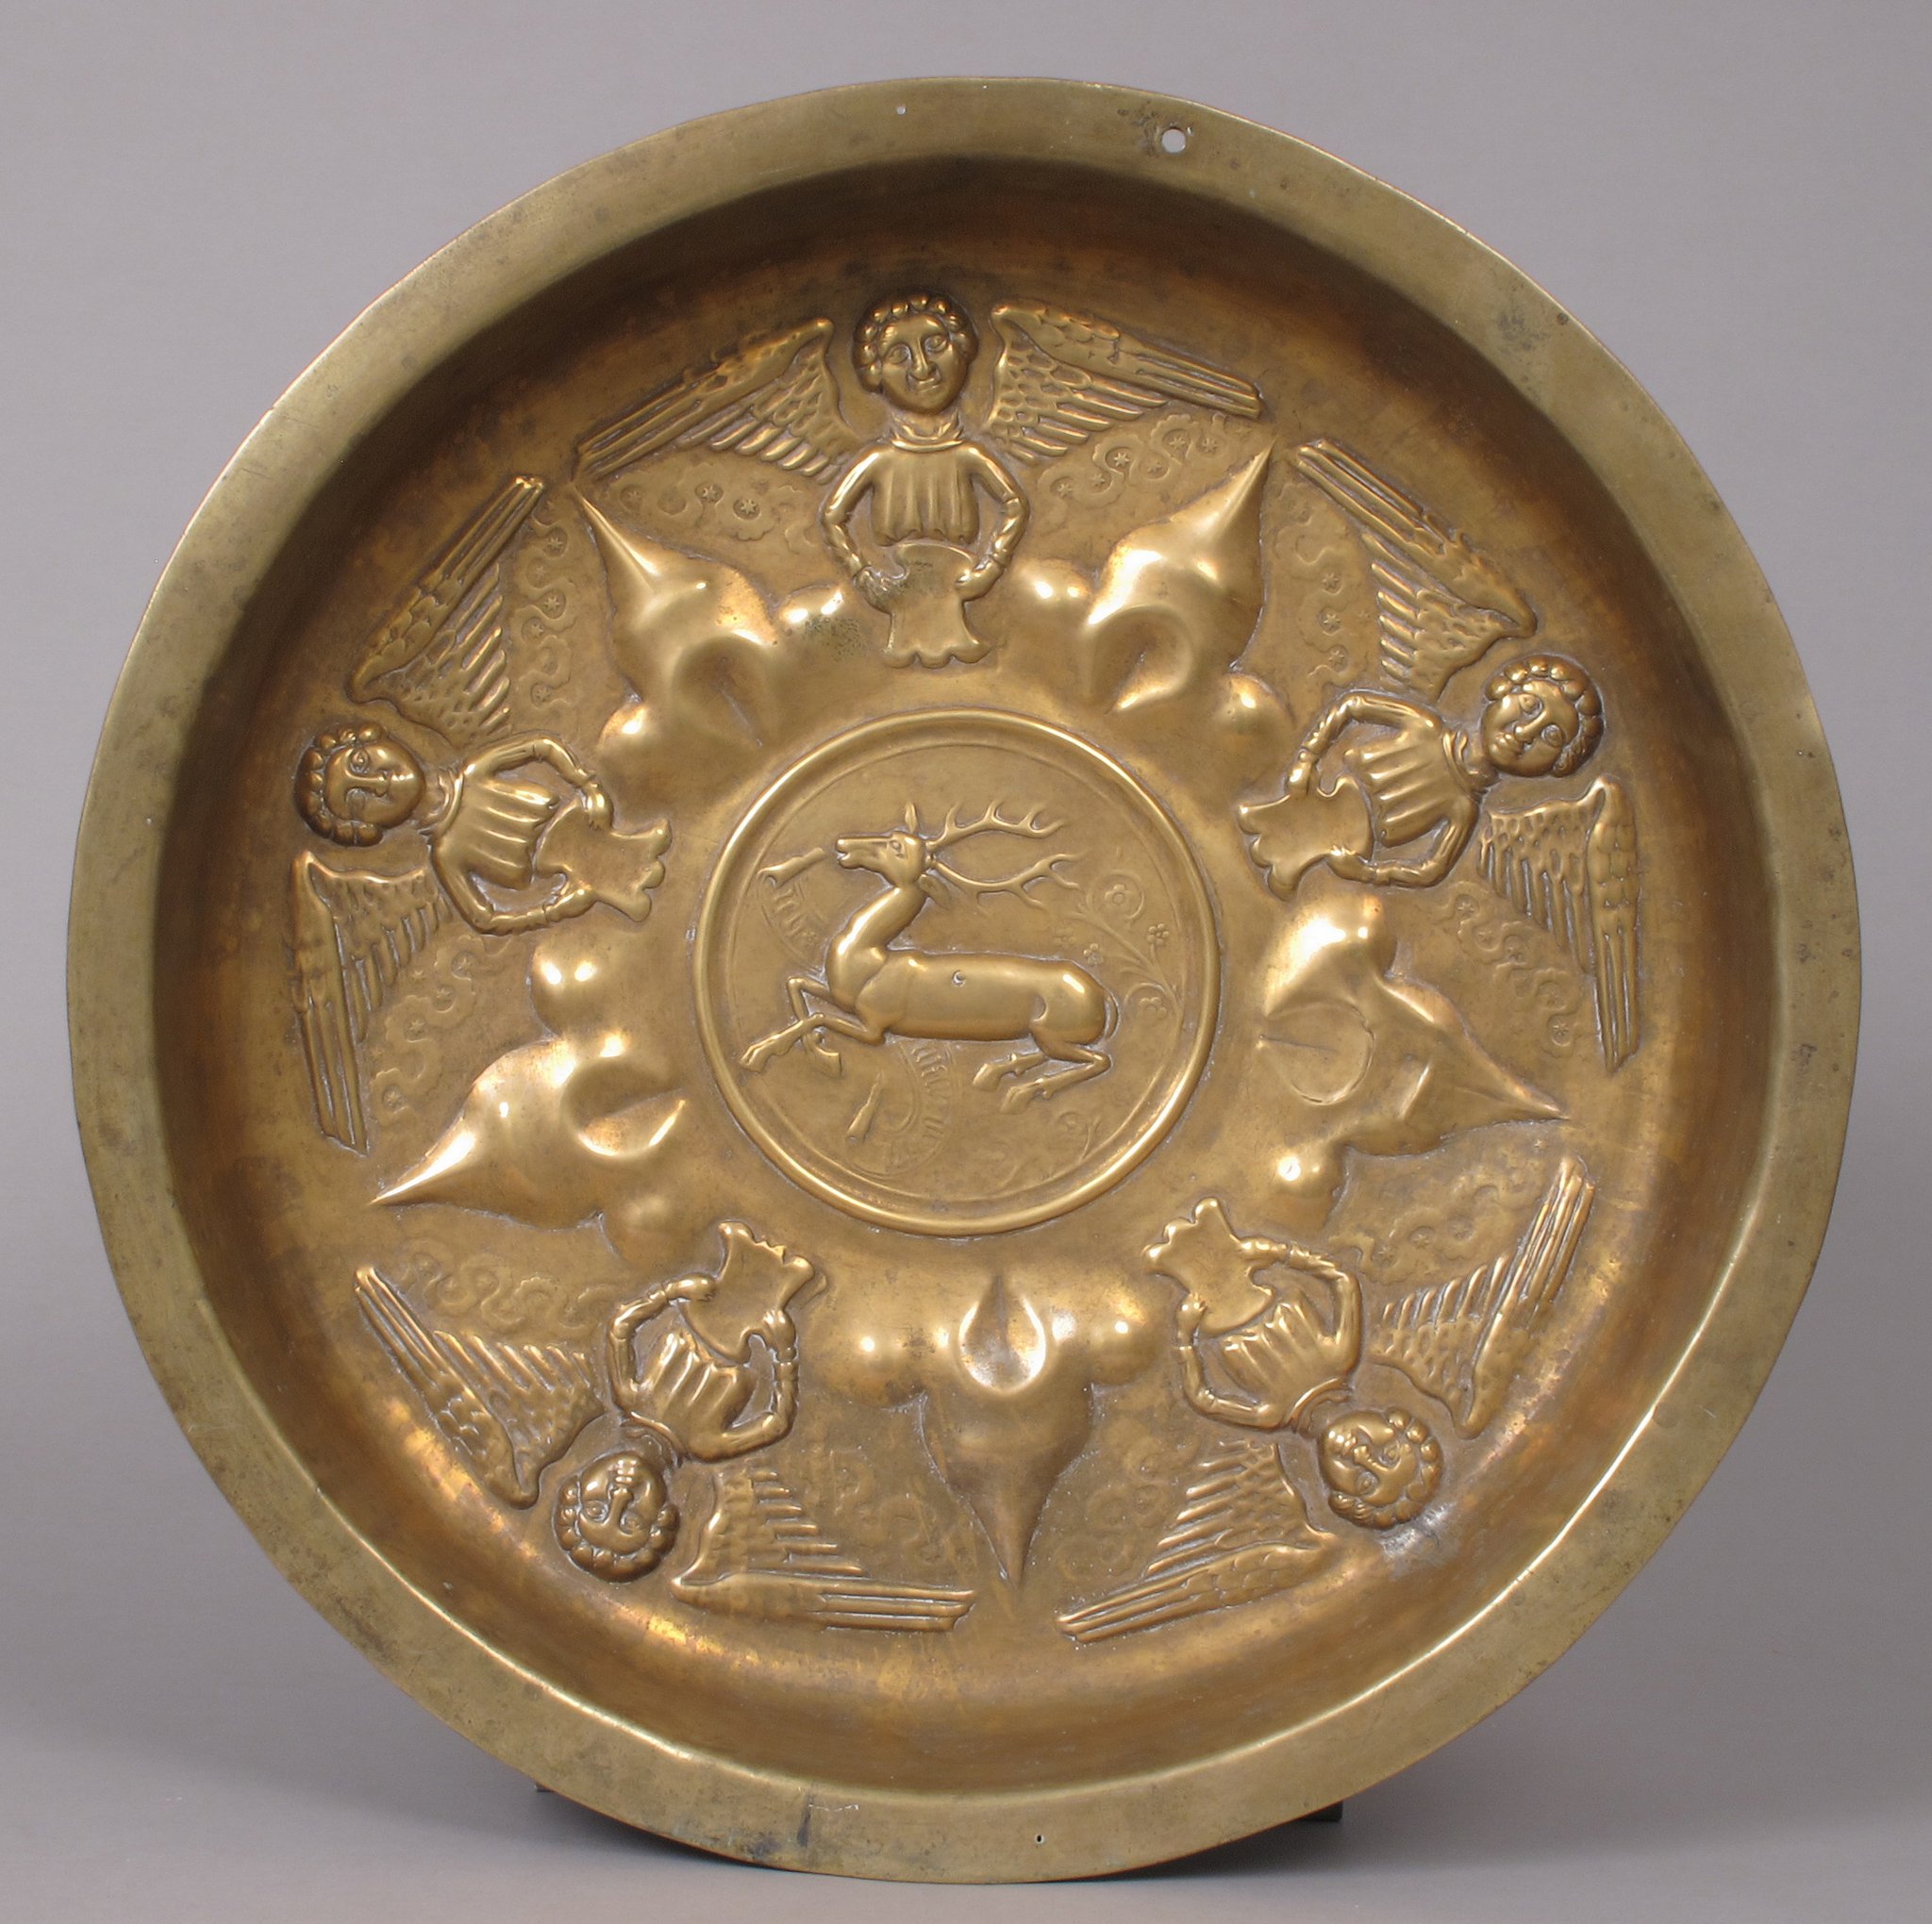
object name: dish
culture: german or south netherlandish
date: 1467-1500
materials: brass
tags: deer